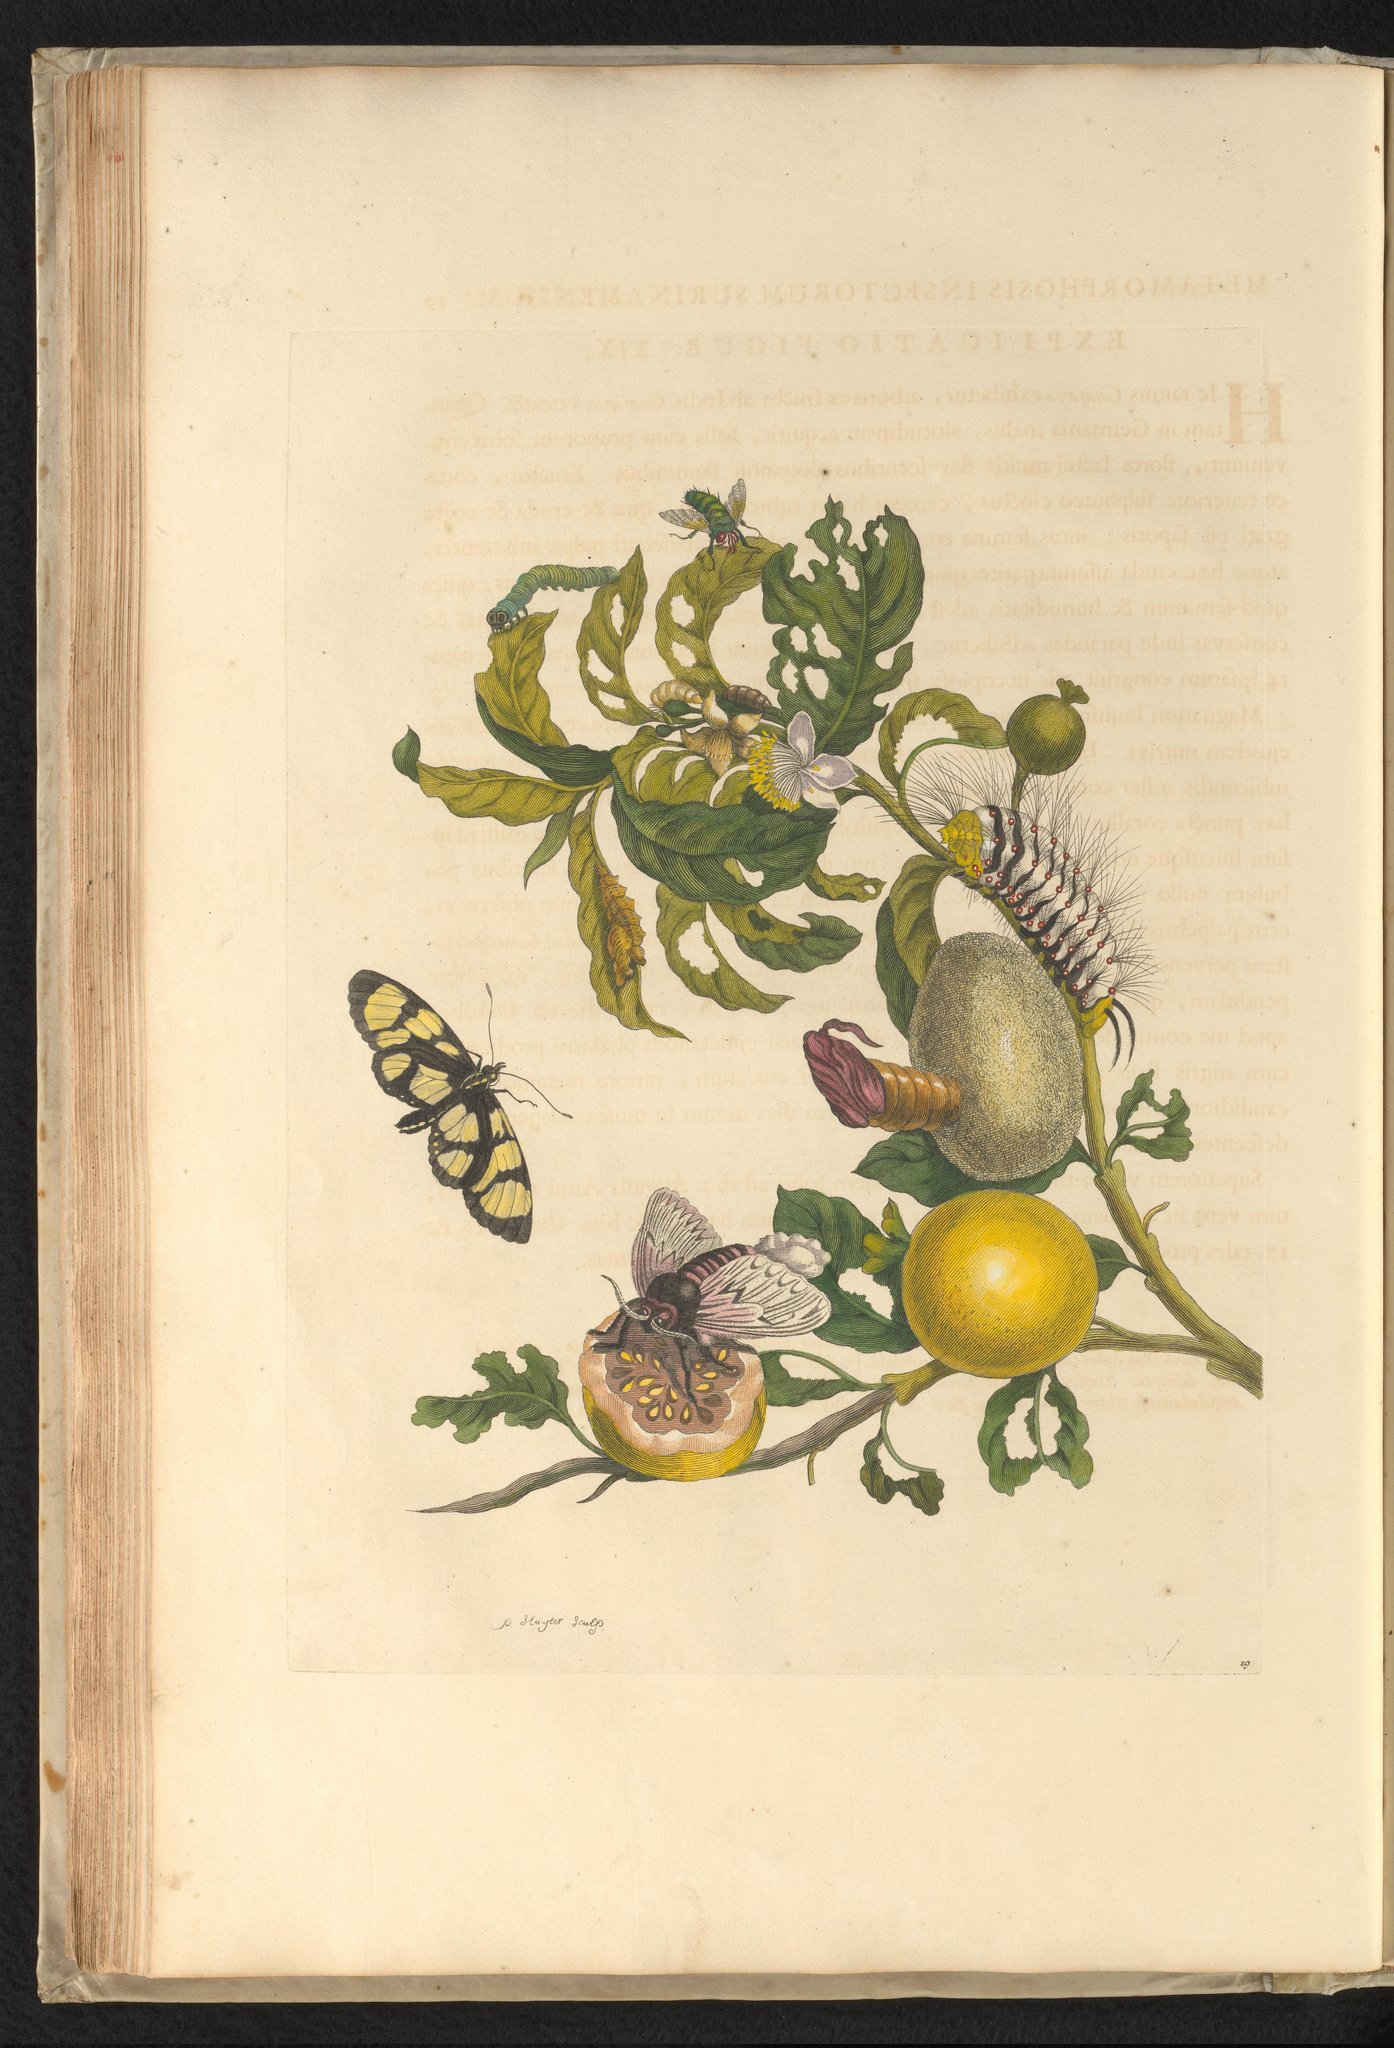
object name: page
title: Guave (Psidium guajava) met vlinder, mot, rupsen en andere insecten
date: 1705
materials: paper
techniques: etching, hand coloring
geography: amsterdam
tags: trees: guave, insects: moth, insects: butterfly, insects: caterpillar, suriname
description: Rechtsonder genummerd: 19. Prent maakt deel uit van een boek.